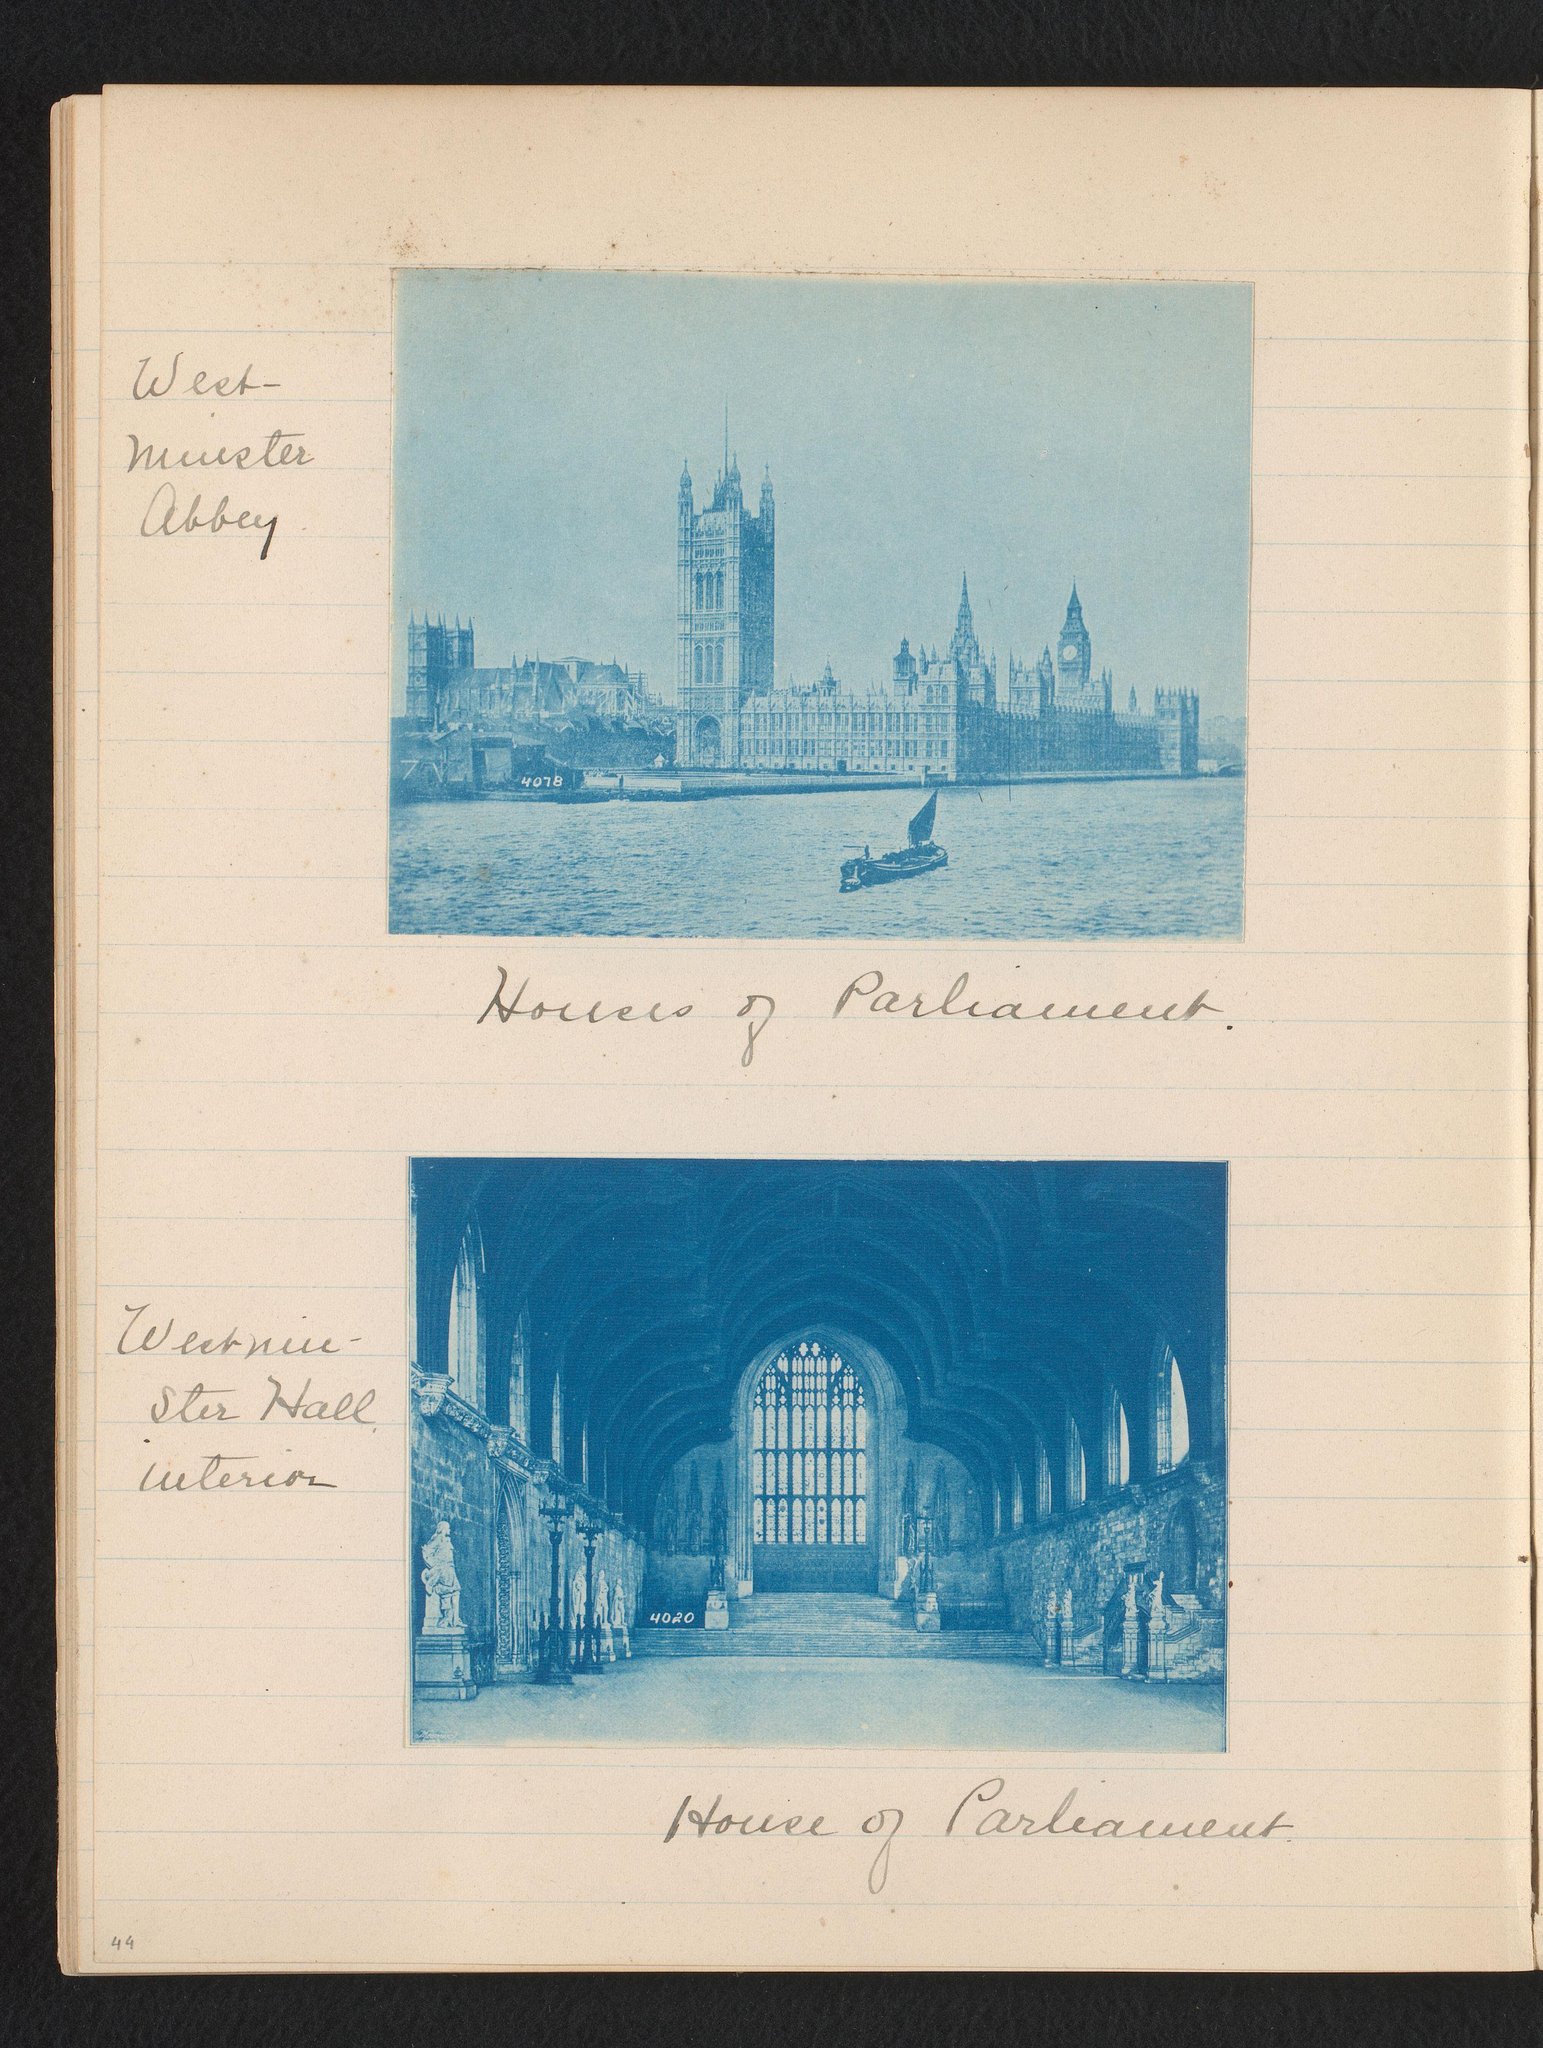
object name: album leaf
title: Twee foto's van het exterieur en interieur van de Houses of Parliament, Londen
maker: Anonymous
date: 1901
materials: paper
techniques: cyanotype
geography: london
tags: lower house, parliament, chamber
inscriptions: inscription: ‘West-/ minster/ Abbey/ Houses of Parliament./ Westmin-/ ster Hall/ interior/ House of Parliament.’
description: Deze foto's maken deel uit van een album.